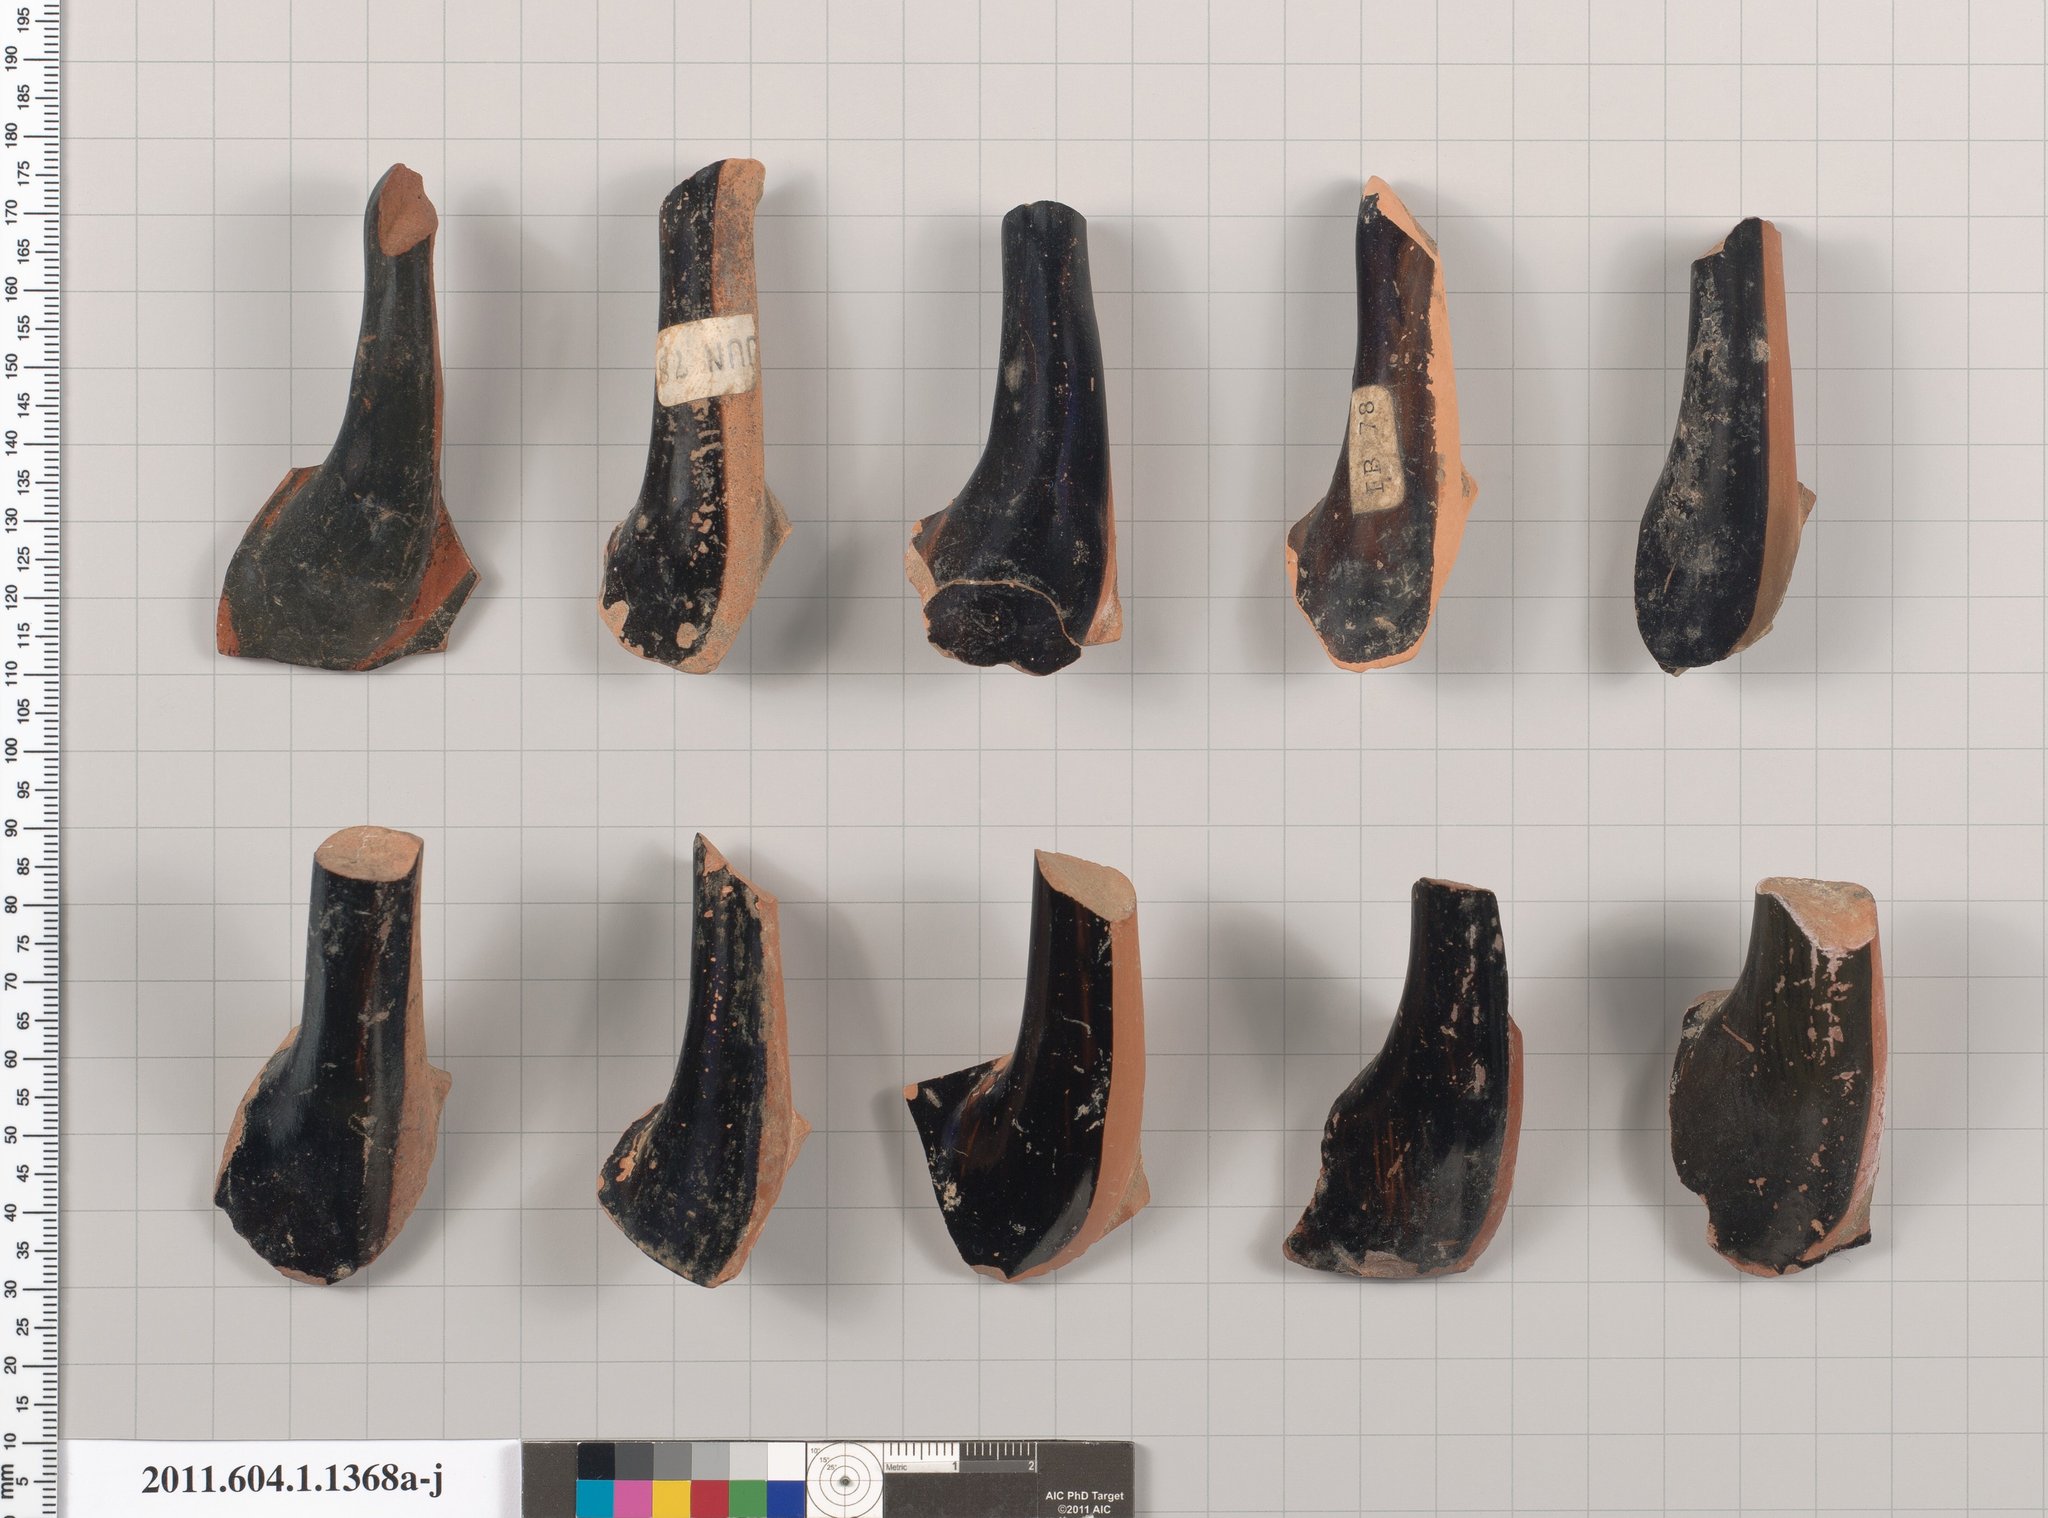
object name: kylix fragment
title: Terracotta fragments of kylikes (drinking cups)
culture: greek, attic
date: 500-401 BCE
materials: terracotta